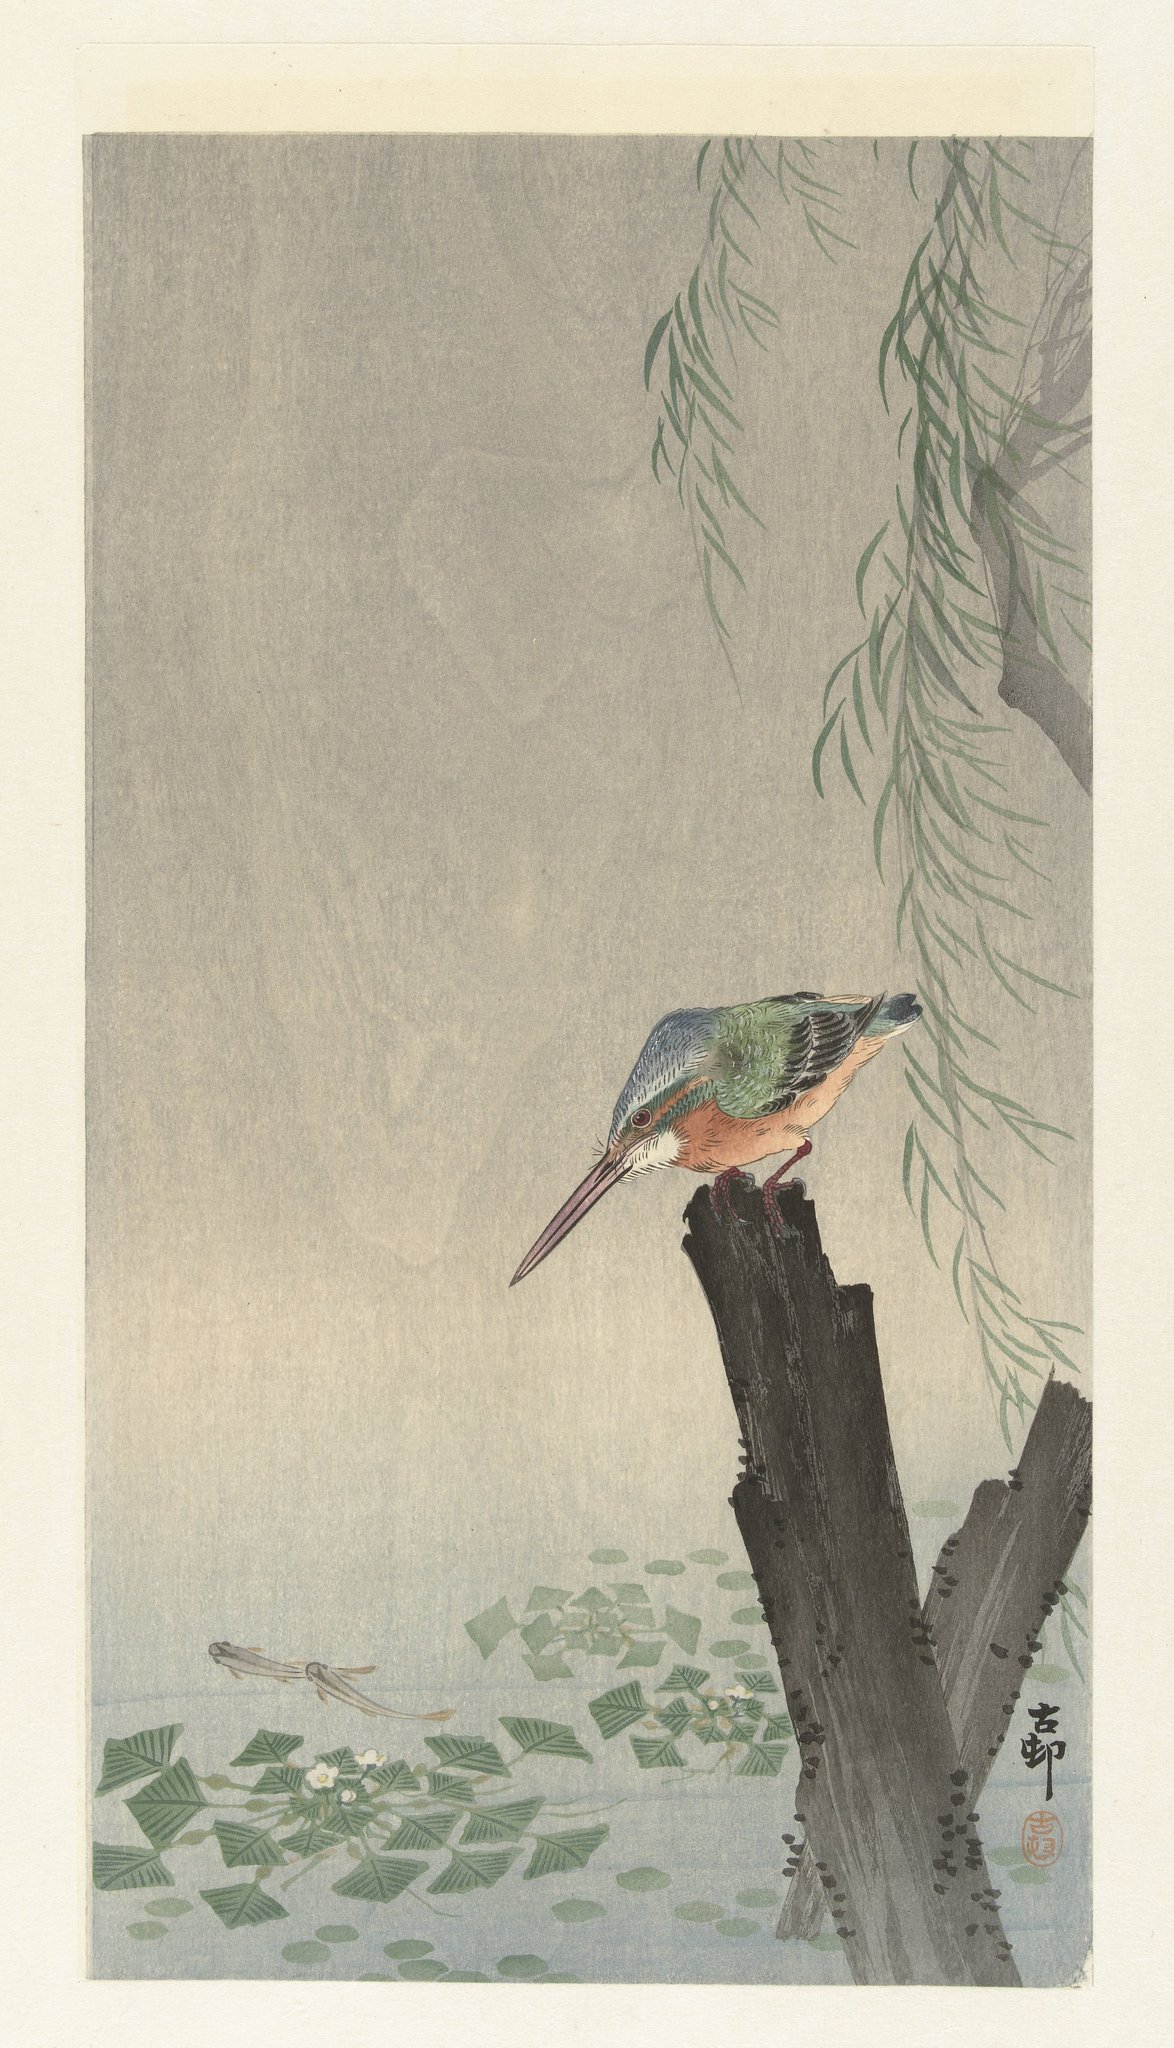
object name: print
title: IJsvogel op boomstronk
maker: ohara koson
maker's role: print maker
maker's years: 1877-1945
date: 1900-1936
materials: paper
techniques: woodcut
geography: japan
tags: water course, other birds: kingfisher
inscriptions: collector's mark: Lugt 2228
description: IJsvogel op een boomstronk, loerend naar twee visjes in het water. Rechtsboven wilgentakken.